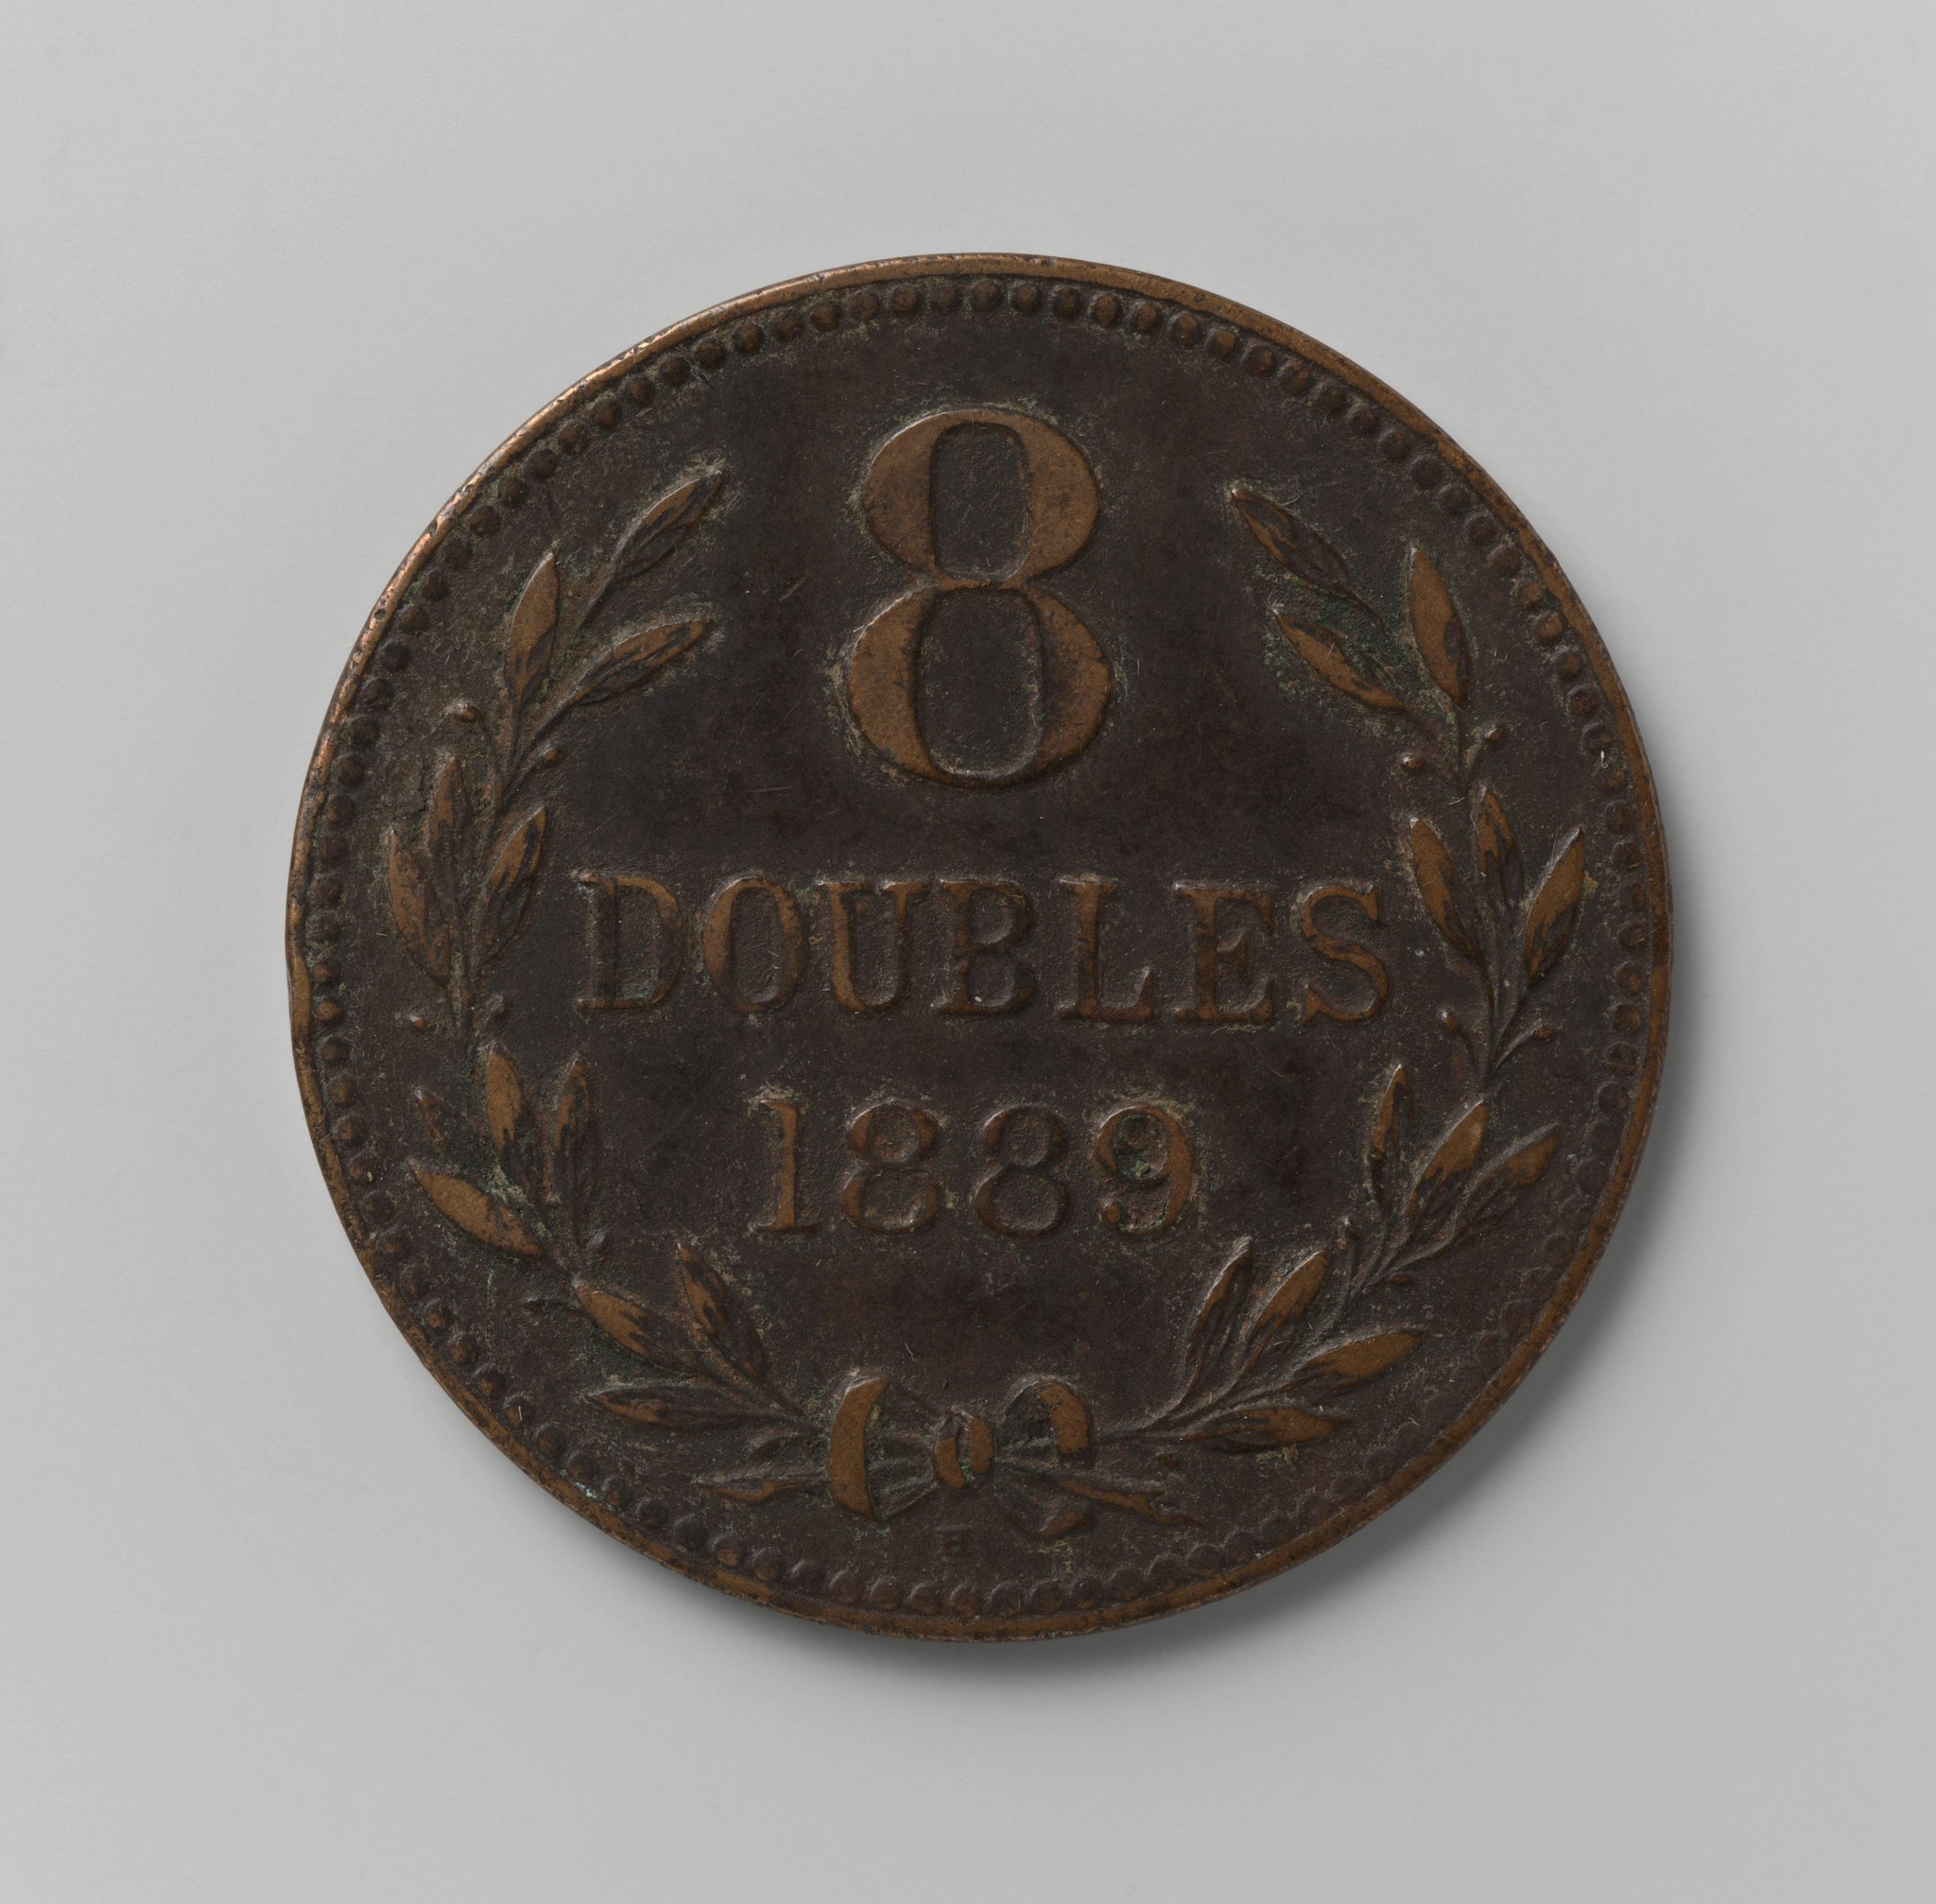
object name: coin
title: 8 doubles uit Guernsey van Victoria, 1889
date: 1889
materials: copper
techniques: striking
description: Koperen munt. Voorzijde: tussen twee samengebonden lauriertakken wapenschild, waarboven landsaanduiding. Keerzijde: binnen twee samengebonden lauriertakkken in twee regels waarde-aanduiding, waaronder jaartal. Gladde rand.